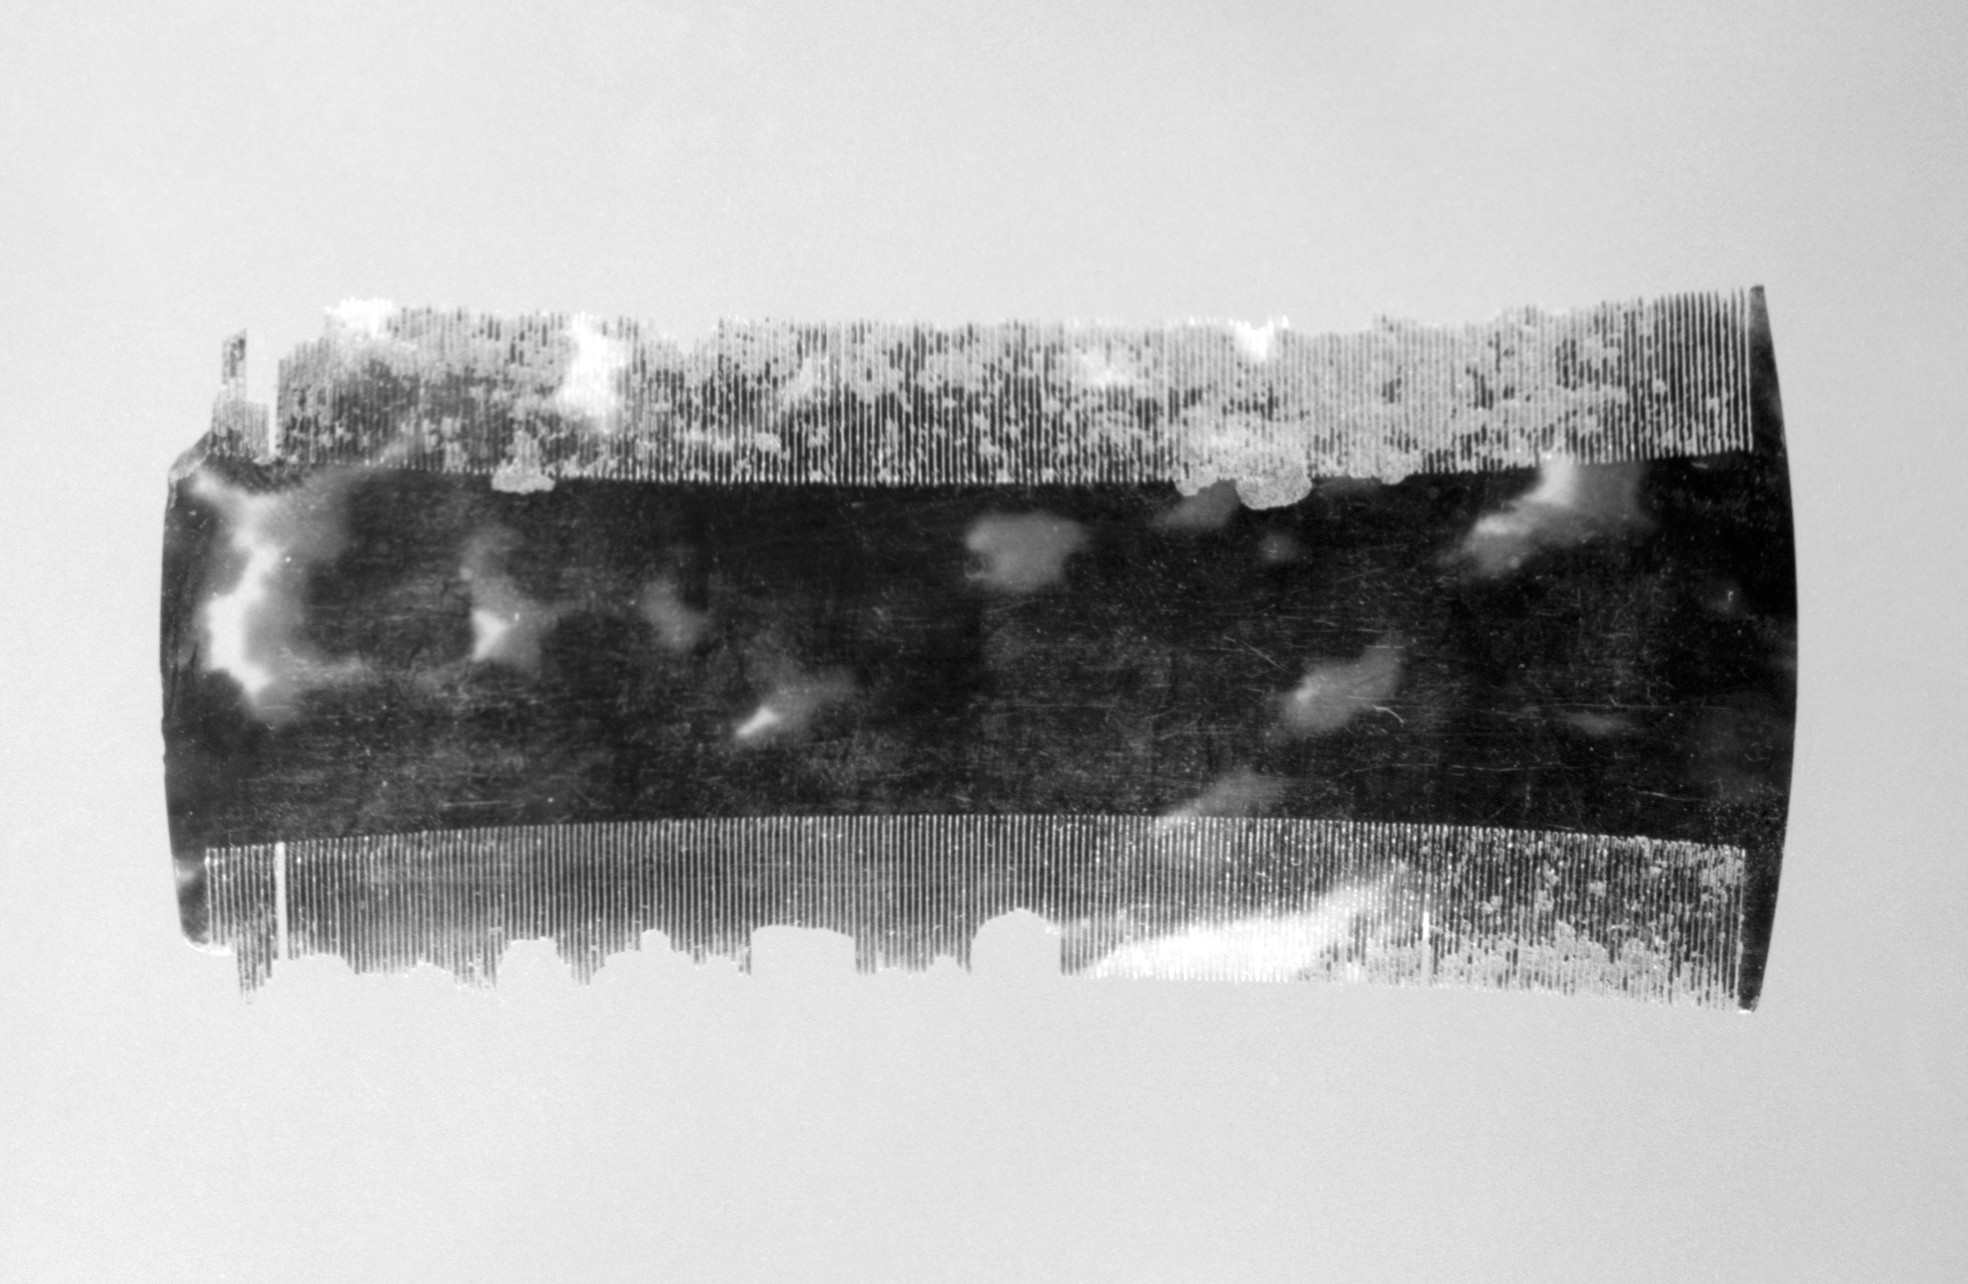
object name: louse comb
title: Lice comb (part of a set)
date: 1848-1849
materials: shell